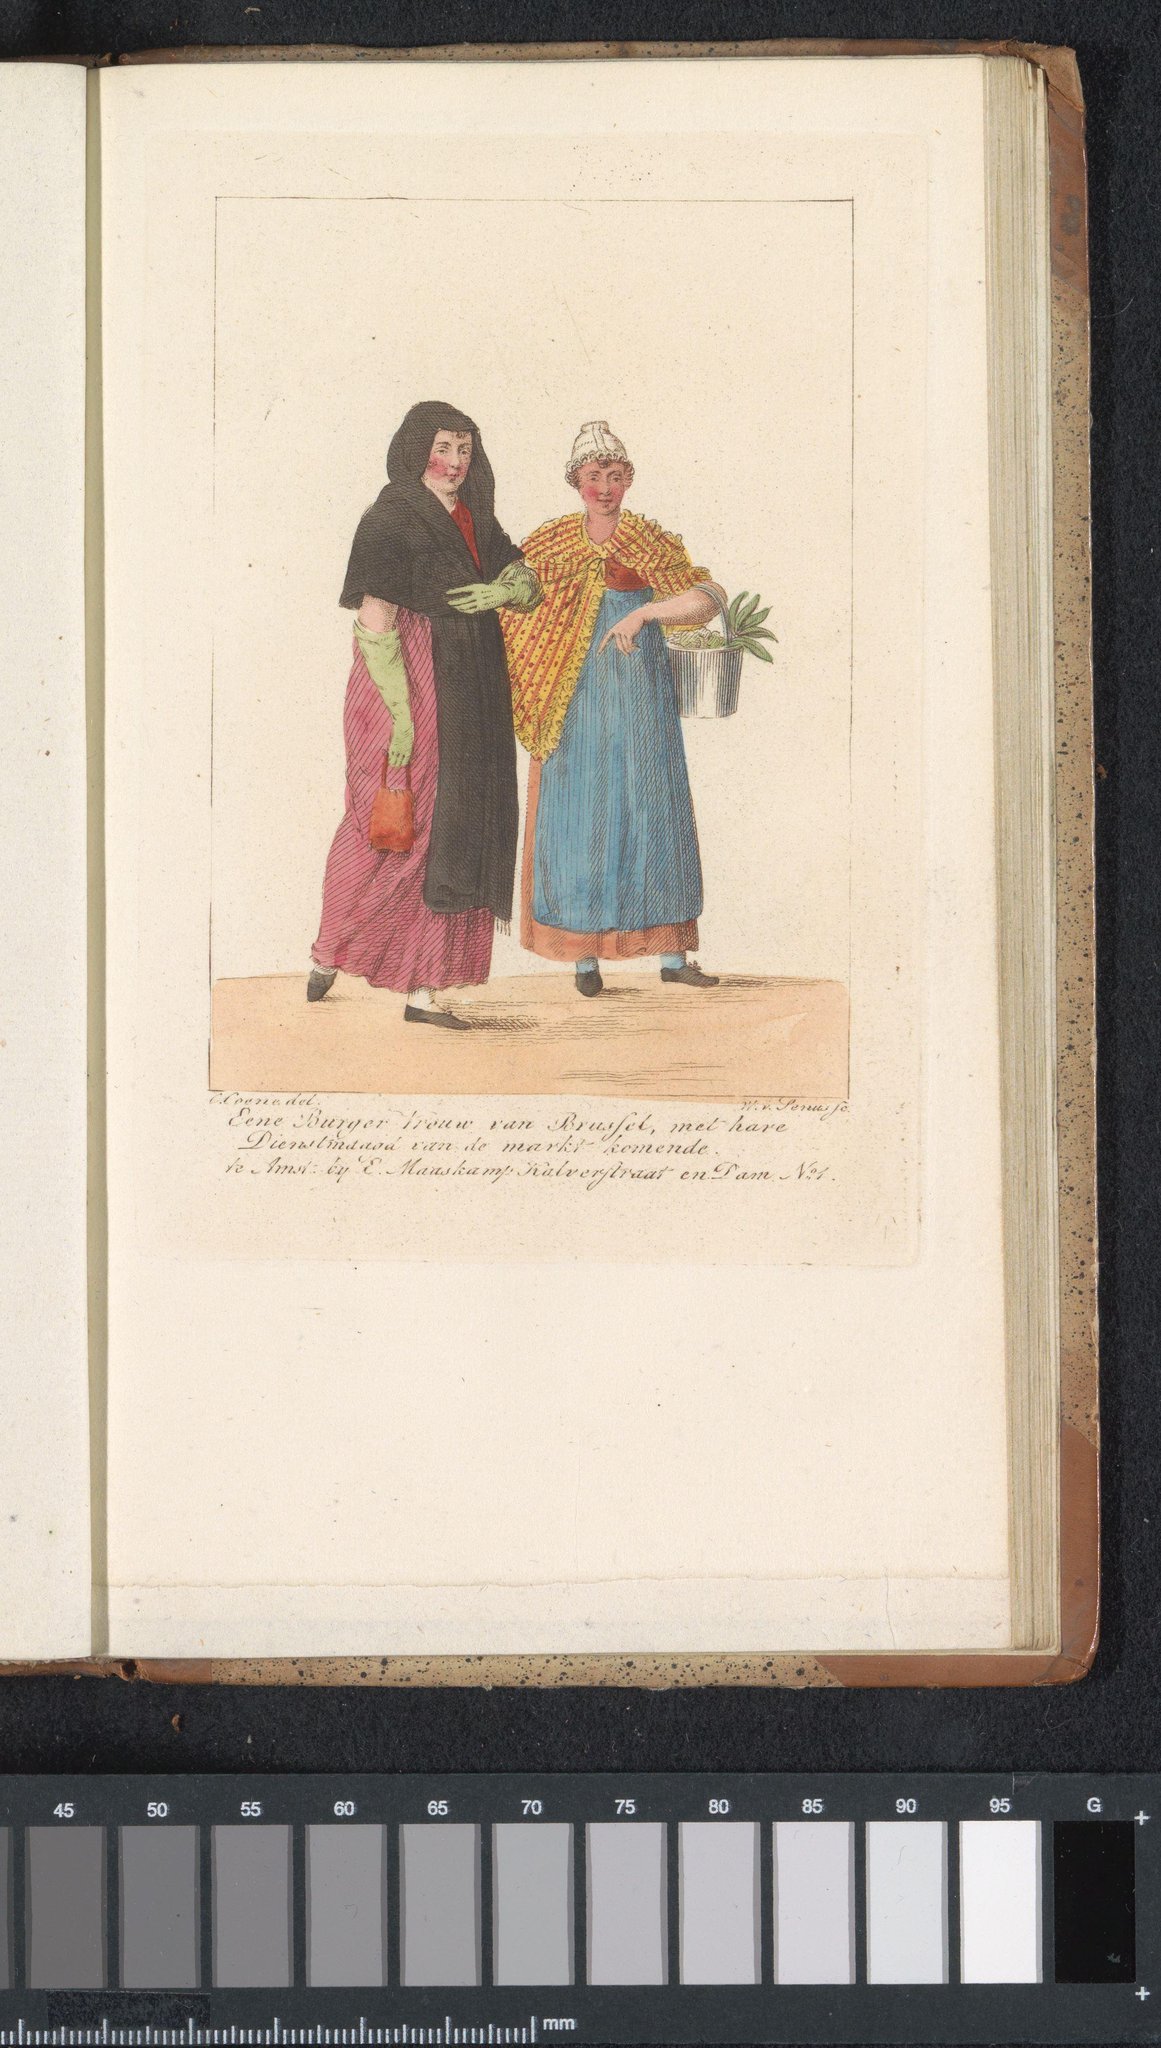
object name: costume print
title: Brusselse vrouw en dienstmeid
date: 1815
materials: paper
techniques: etching, hand coloring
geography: netherlands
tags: folk costume, regional costume, clothes, costume, brussels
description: Een burgervrouw met haar dienstmeid terugkomend van de markt, te Brussel. Illustraties van Vlaamse klederdrachten uit 1815, in aanvulling op de verkleinde kopieën uit 1812 naar de platen van Nederlandse klederdrachten uit de jaren 1803-1807.